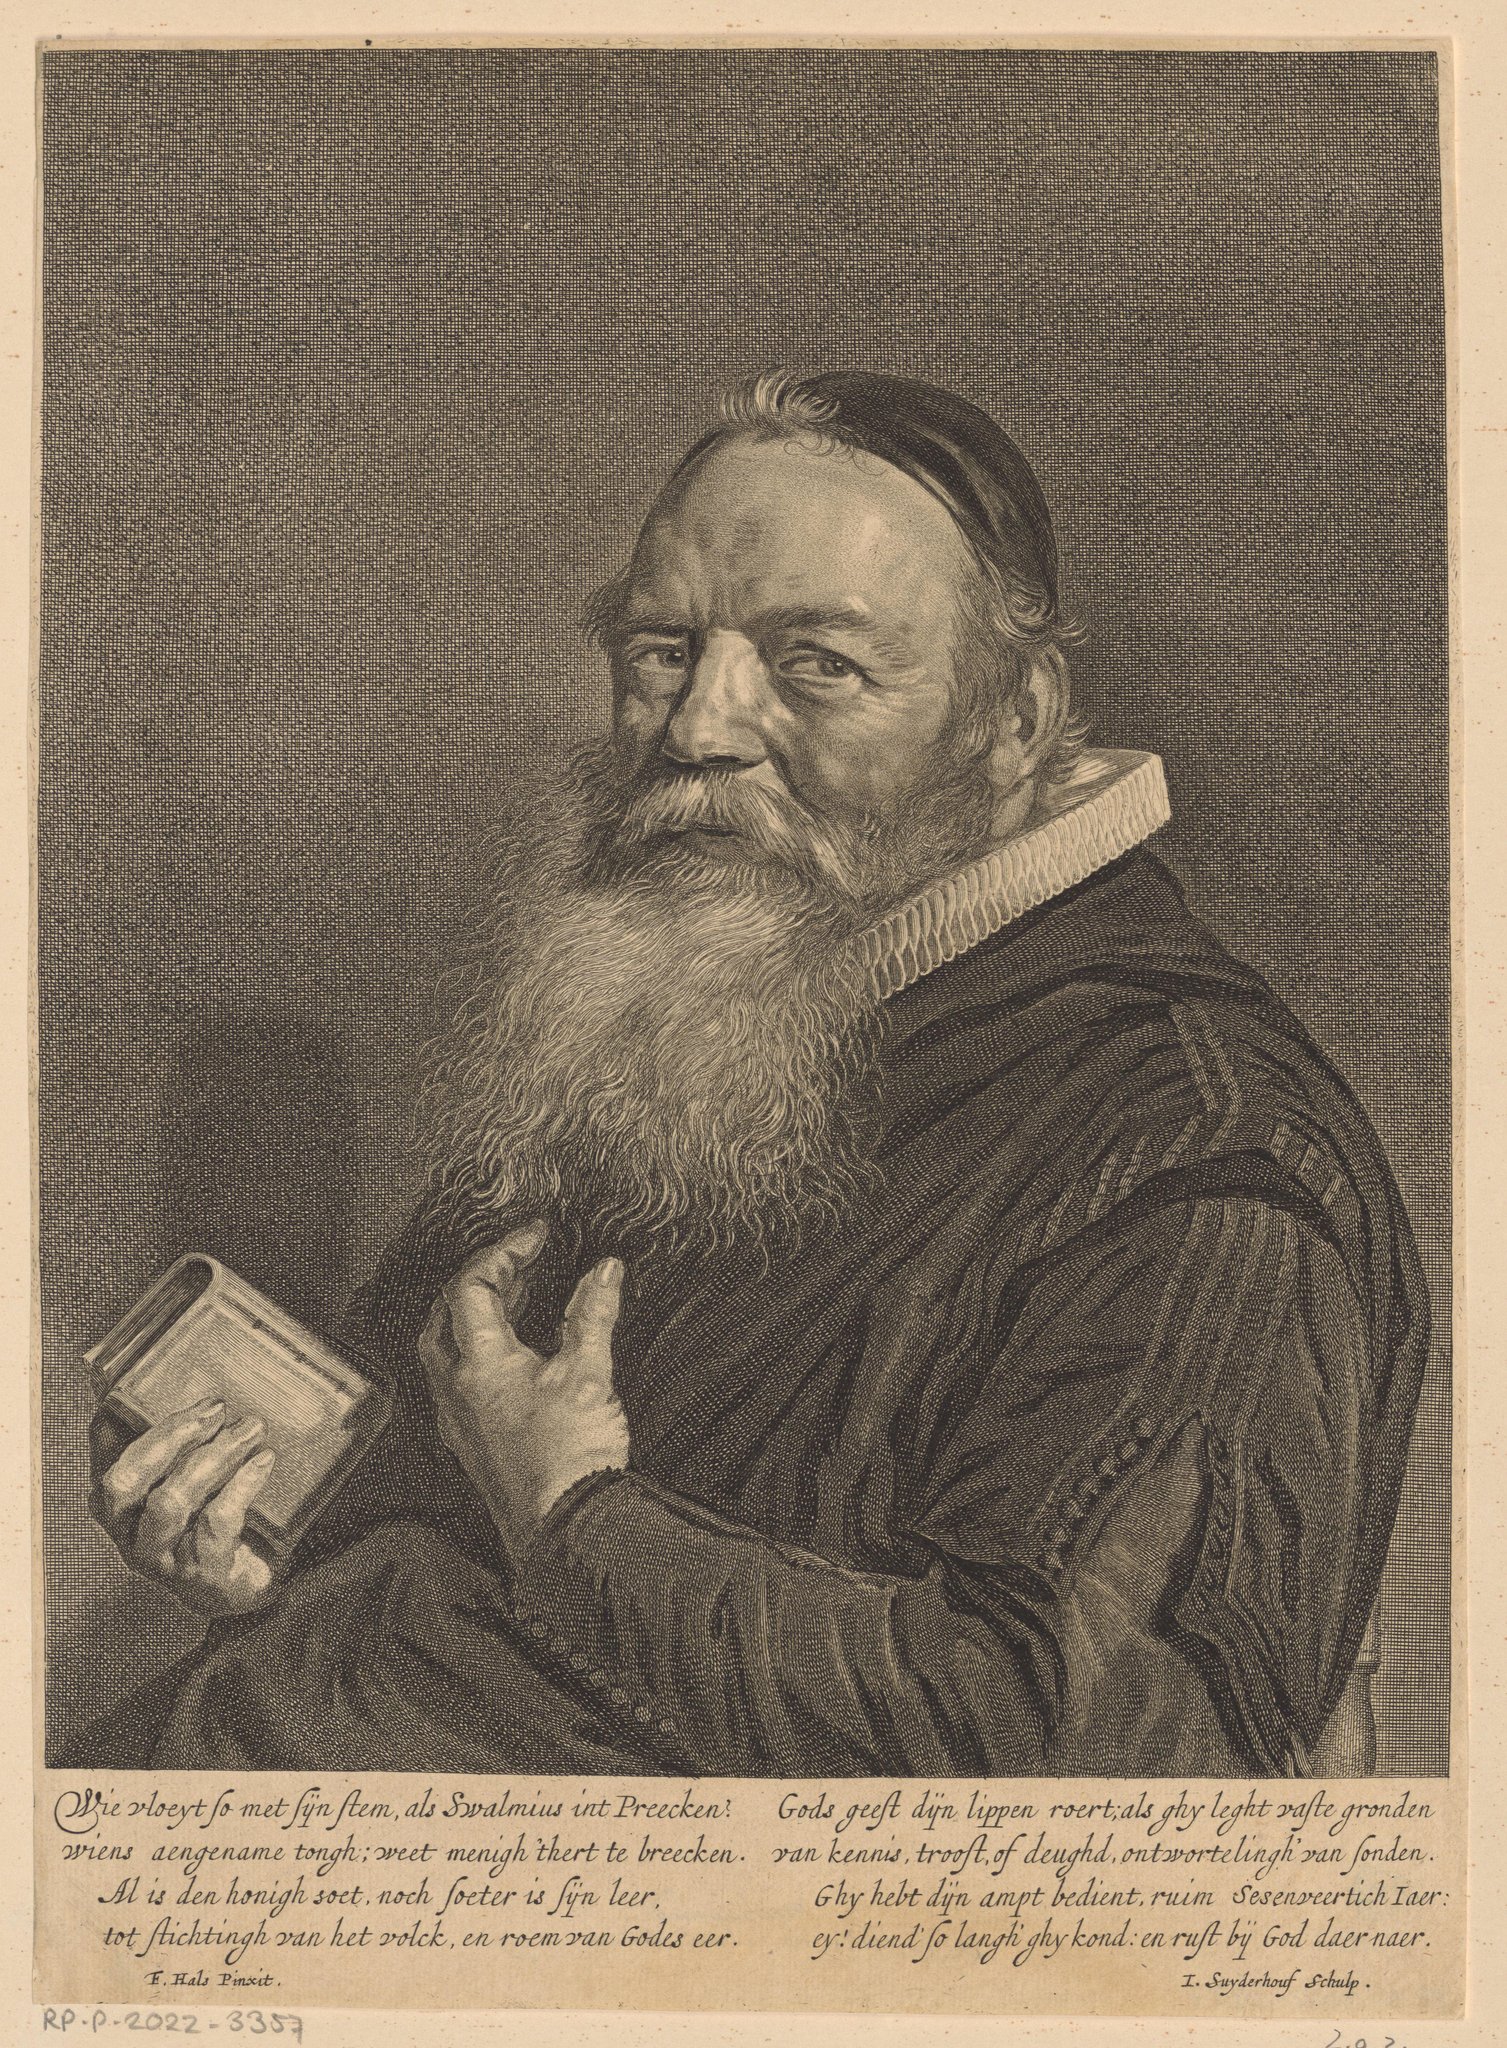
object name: print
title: Portret van Hendrik Swalmius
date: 1639-1686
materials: paper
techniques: engraving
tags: rhoon, historical persons, book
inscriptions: collector's mark: Lugt 567, inscription: ‘[2 ja] terr, maschand anno 1799’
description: Onder het portret een achtregelig vers in het Nederlands.